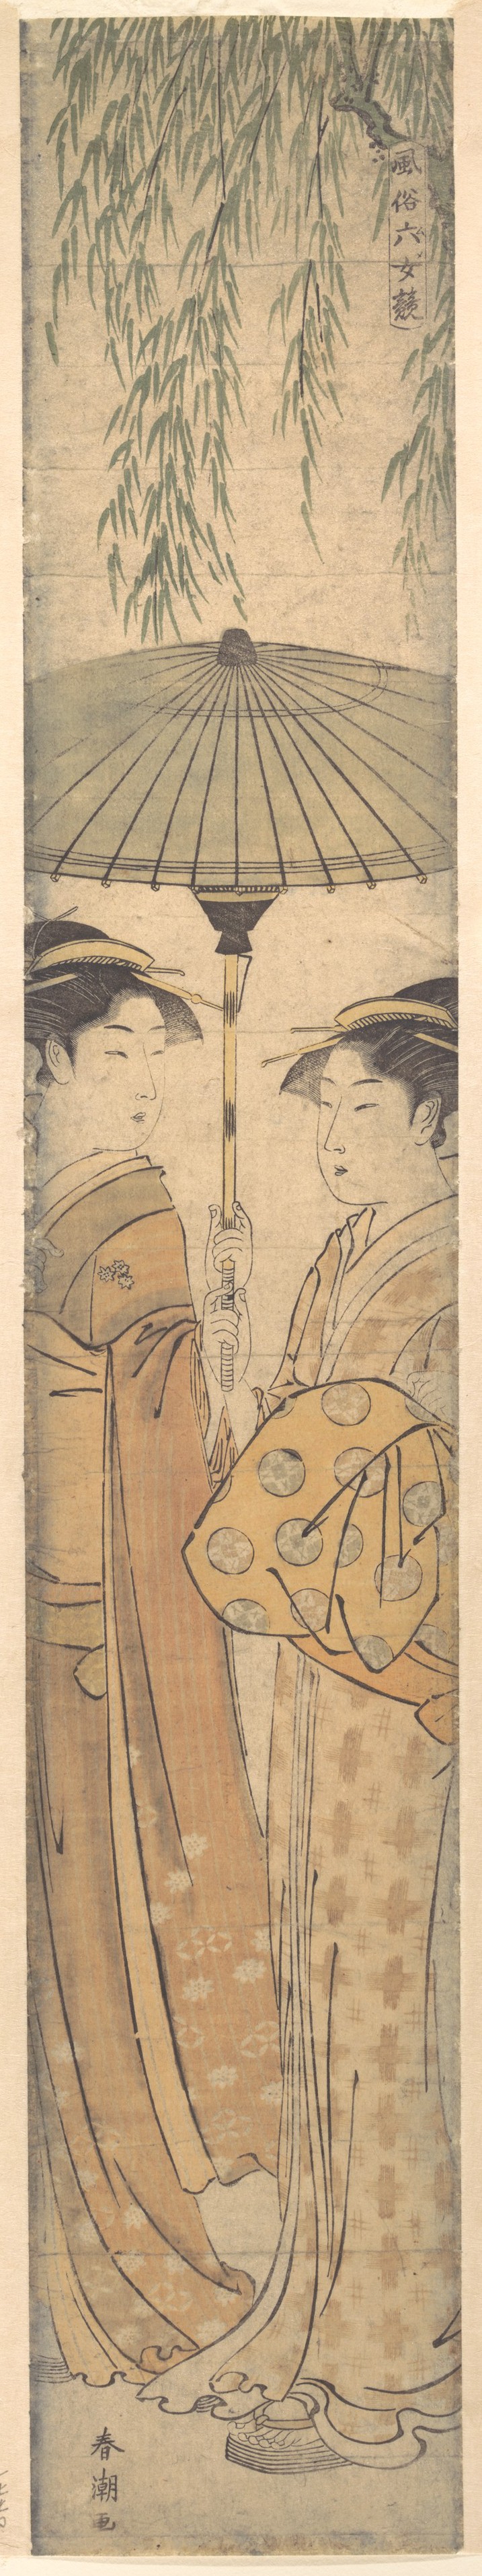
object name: woodblock print nishiki e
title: Beauties under an Umbrella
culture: japanese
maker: katsukawa shunshō 勝川春章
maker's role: artist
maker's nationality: japanese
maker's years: 1726-1792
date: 1767-1800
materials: ink, paper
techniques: nishiki e, woodblock print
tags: women